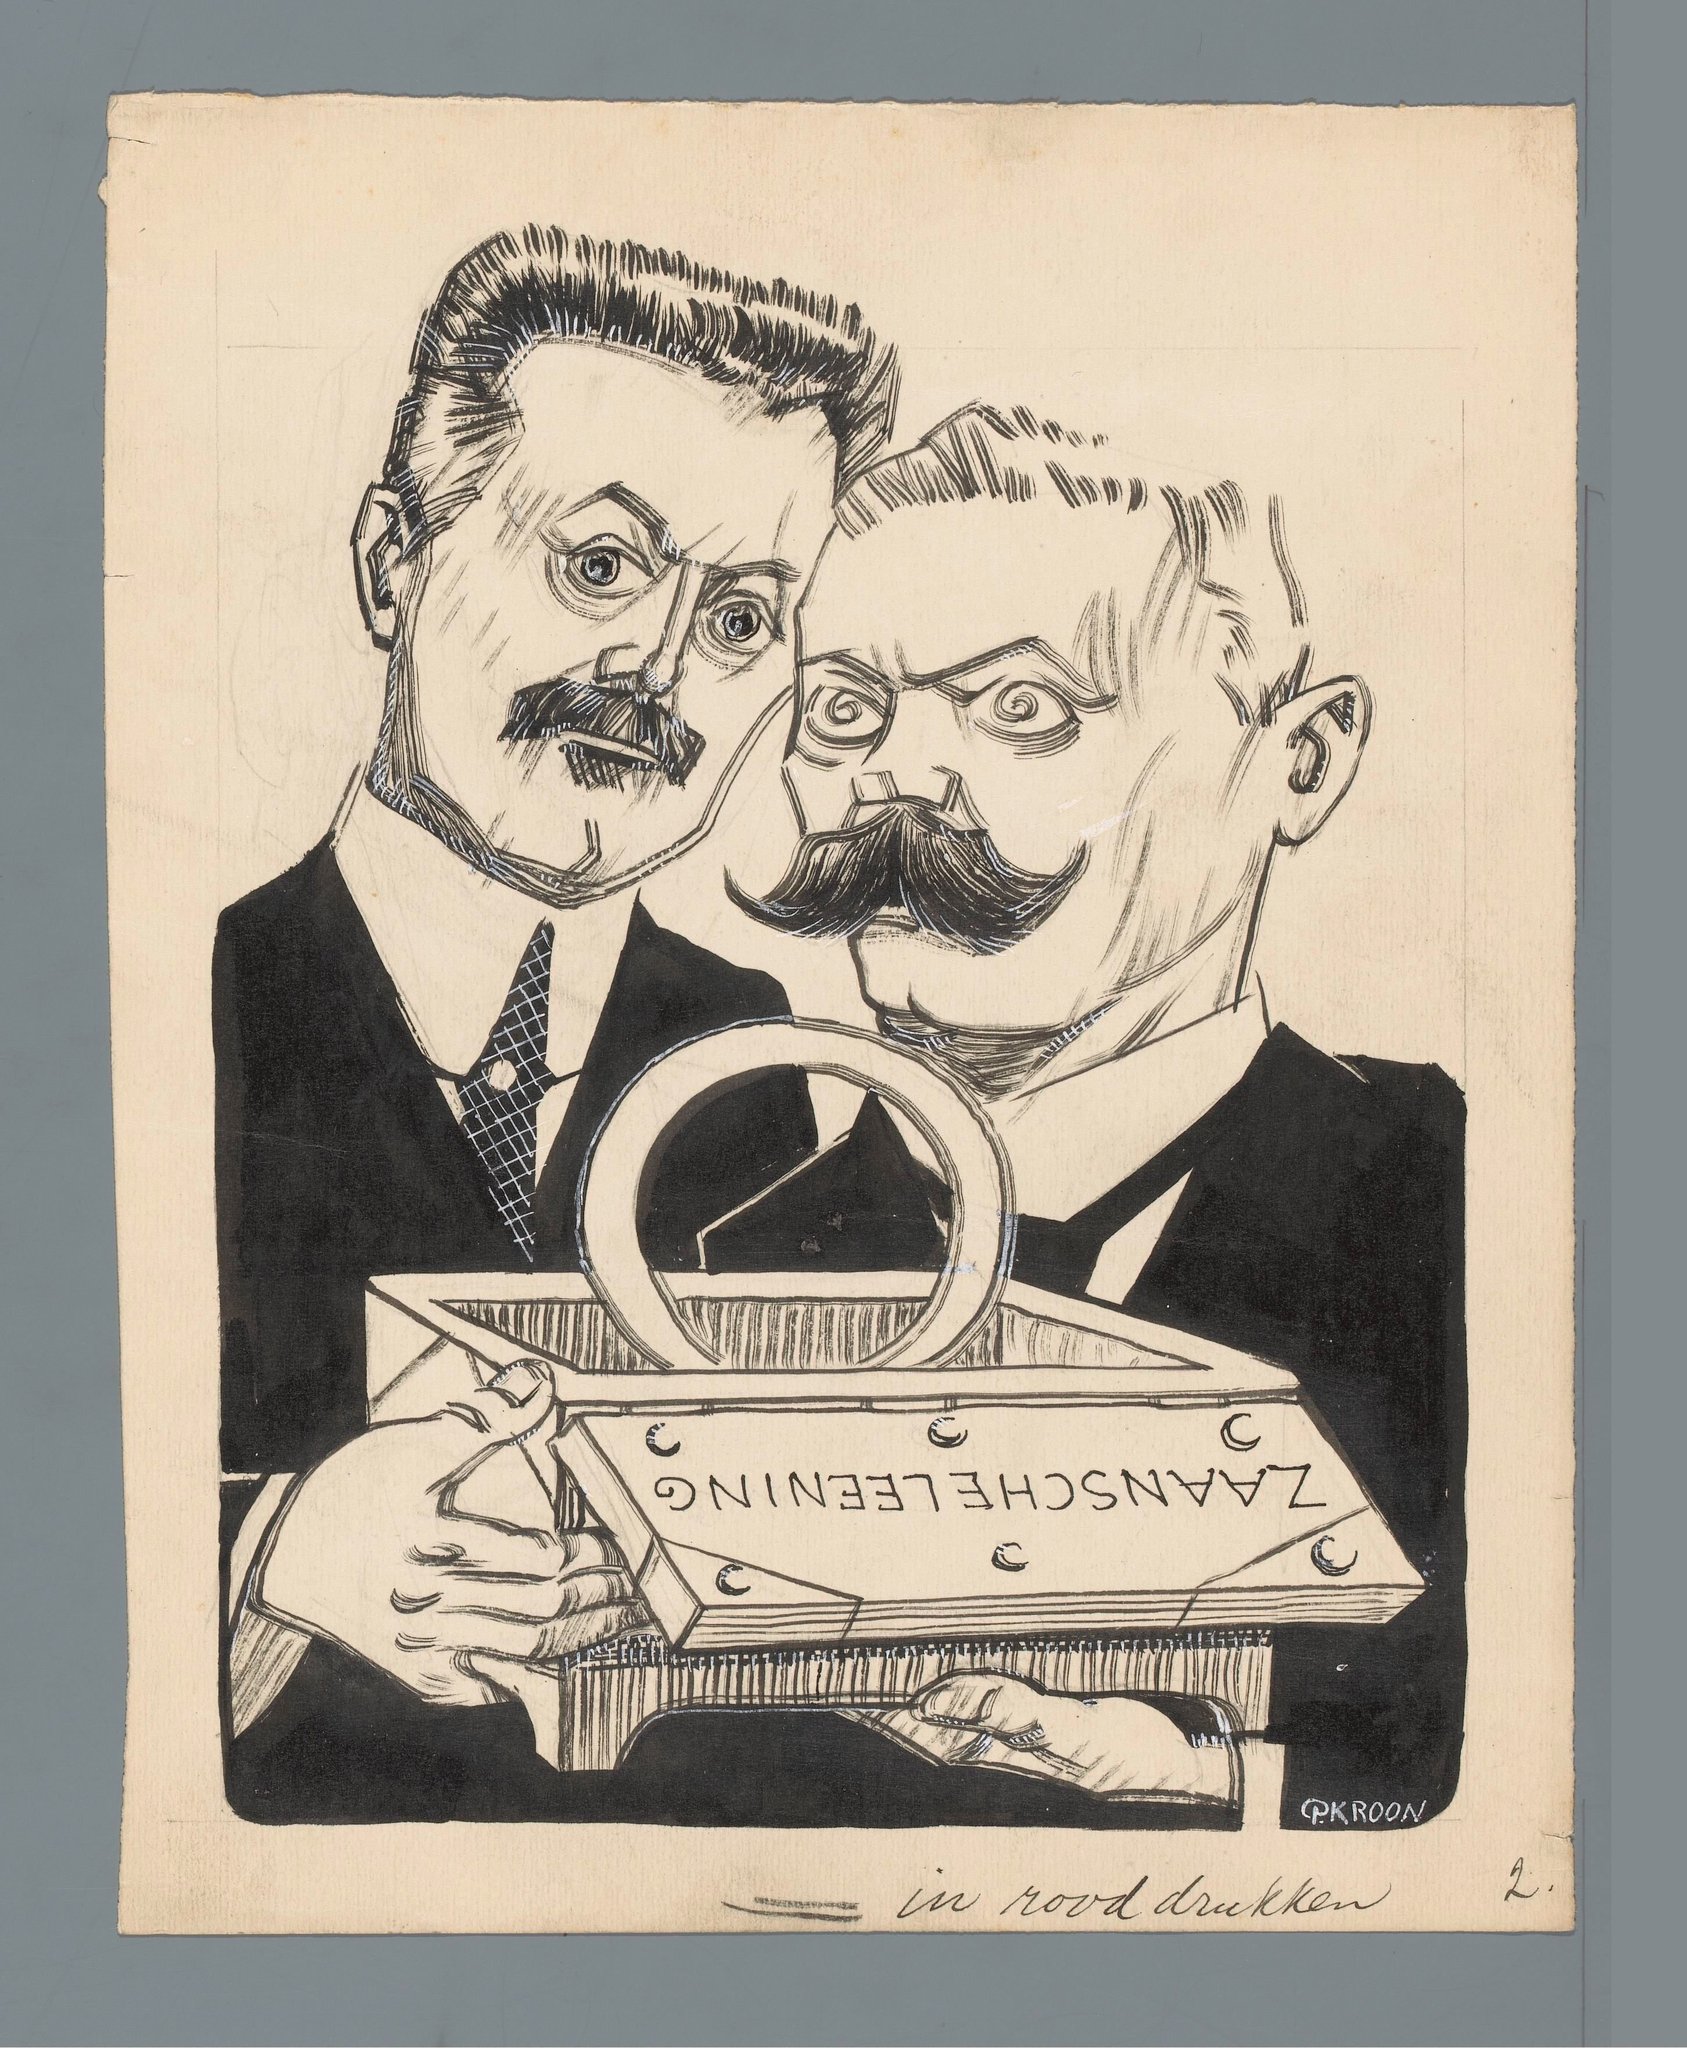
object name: drawing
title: Zaansche leening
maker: patricq kroon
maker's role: draughtsman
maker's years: 1862-1941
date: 1920-1930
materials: ink, paper, pencil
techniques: brush, pen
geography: netherlands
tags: minister ~ government, political caricatures and satires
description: Twee politici met een open kistje aangeduid als 'Zaansche Leening' waarin een grote nul. Ontwerp voor een politieke spotprent.